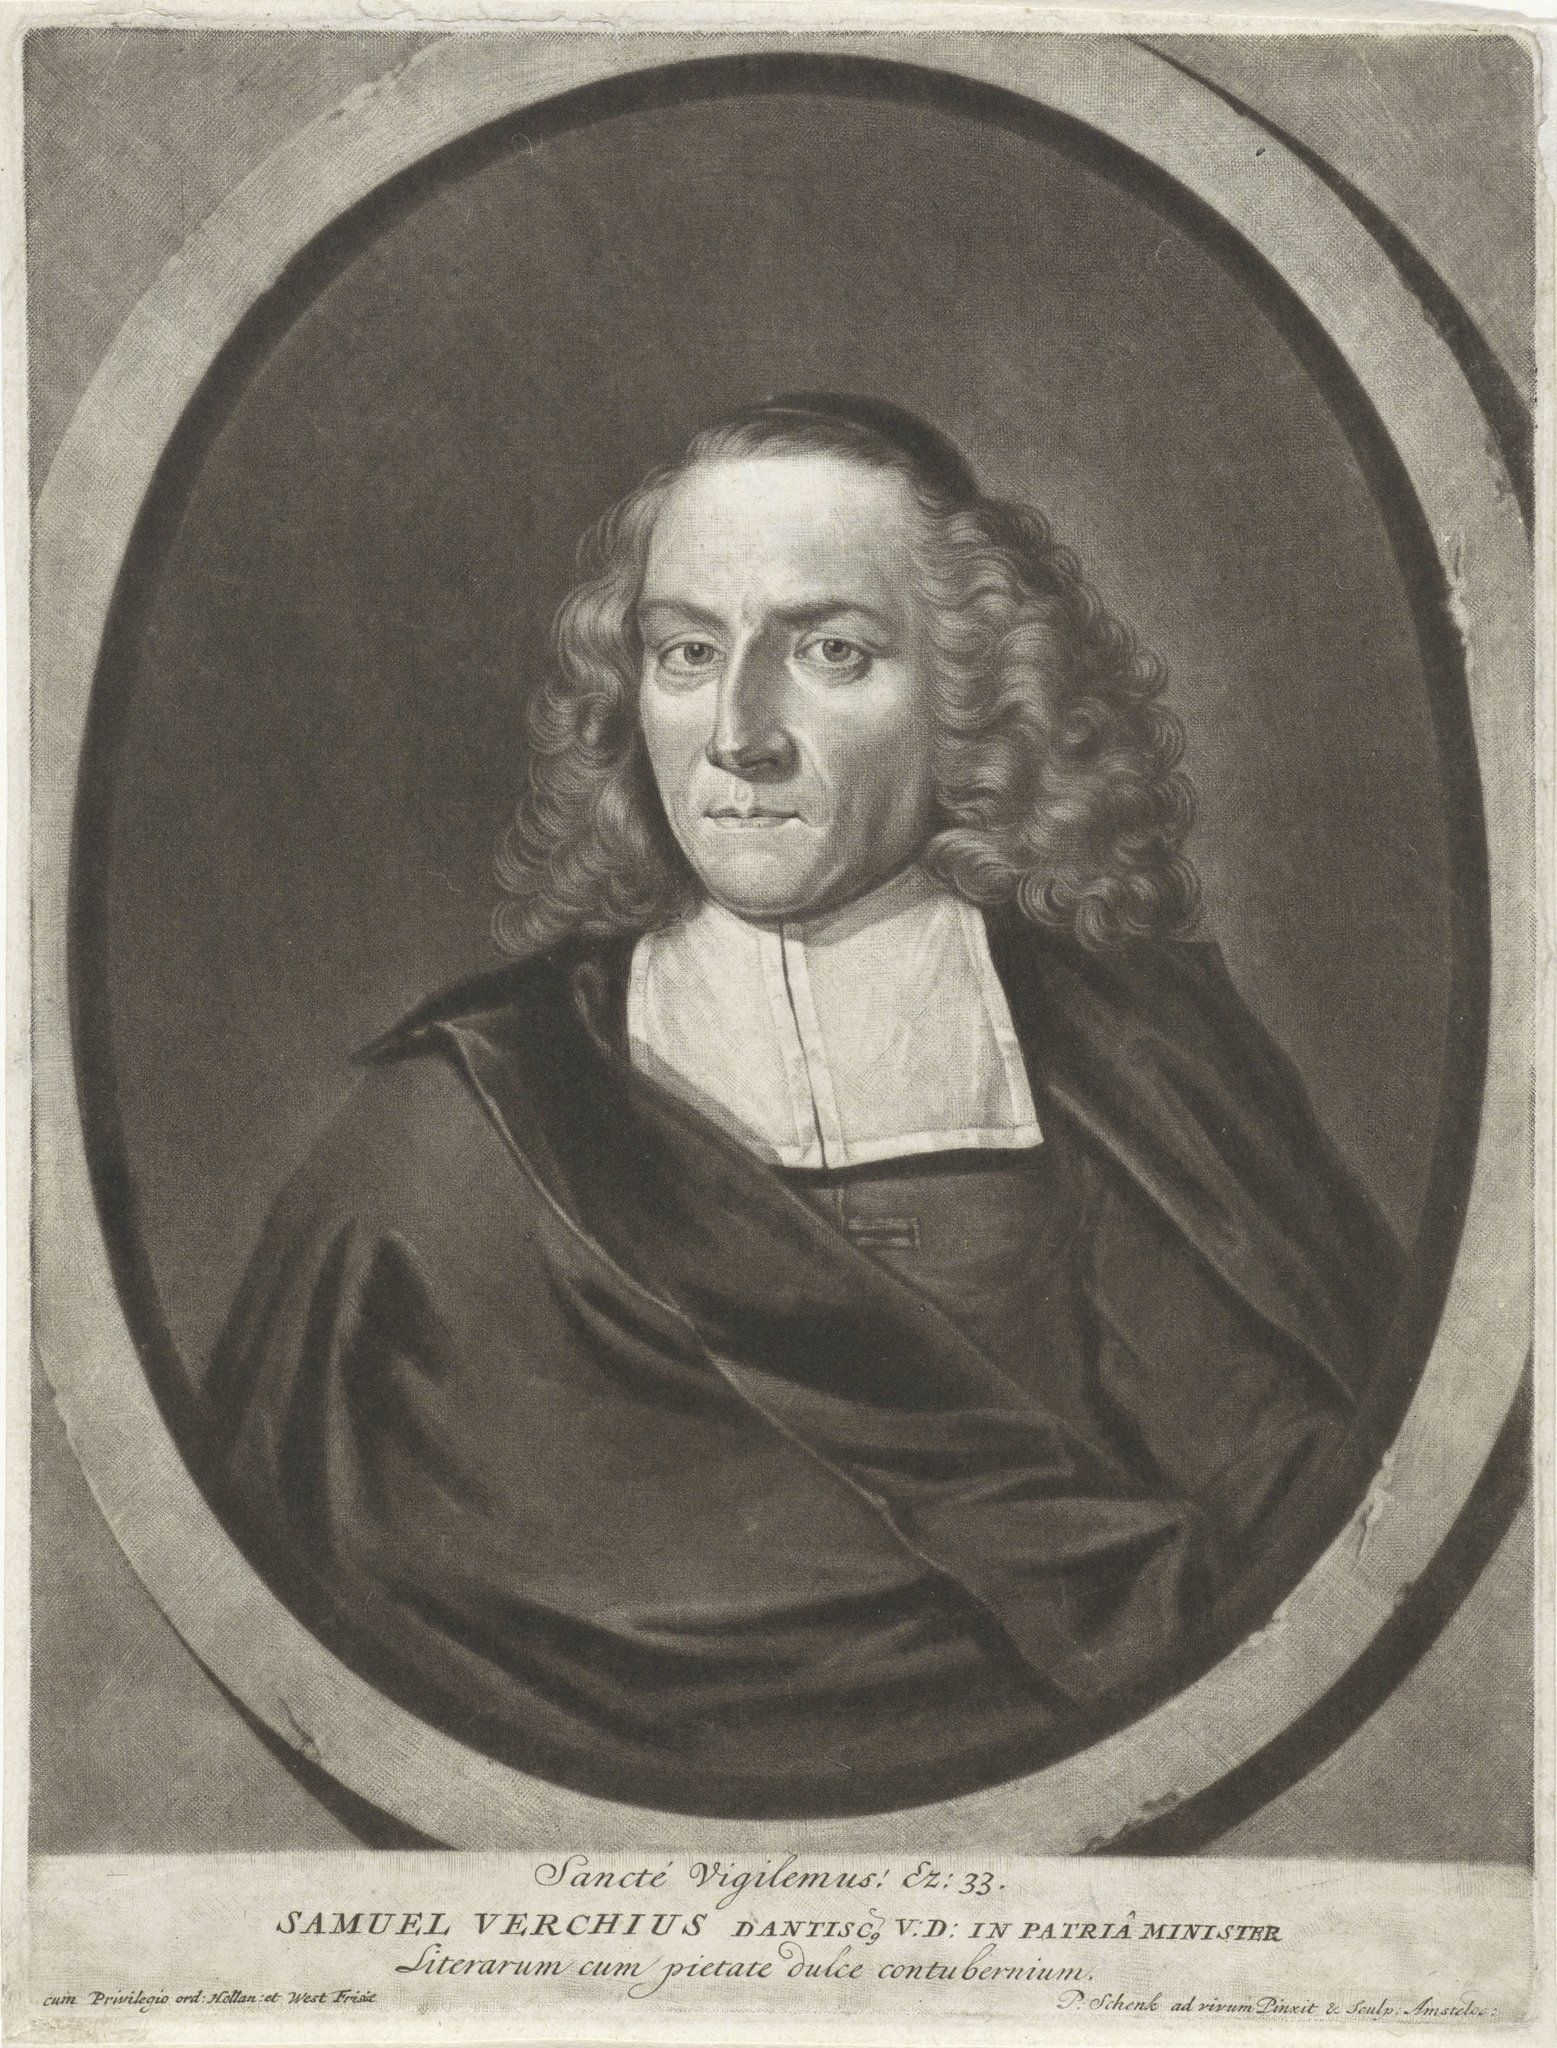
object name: print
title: Portret van de theoloog Samuel Verch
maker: pieter schenk (i)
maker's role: print maker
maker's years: 1660-1711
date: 1670-1713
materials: paper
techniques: engraving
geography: amsterdam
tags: theologian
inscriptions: collector's mark: Lugt 964